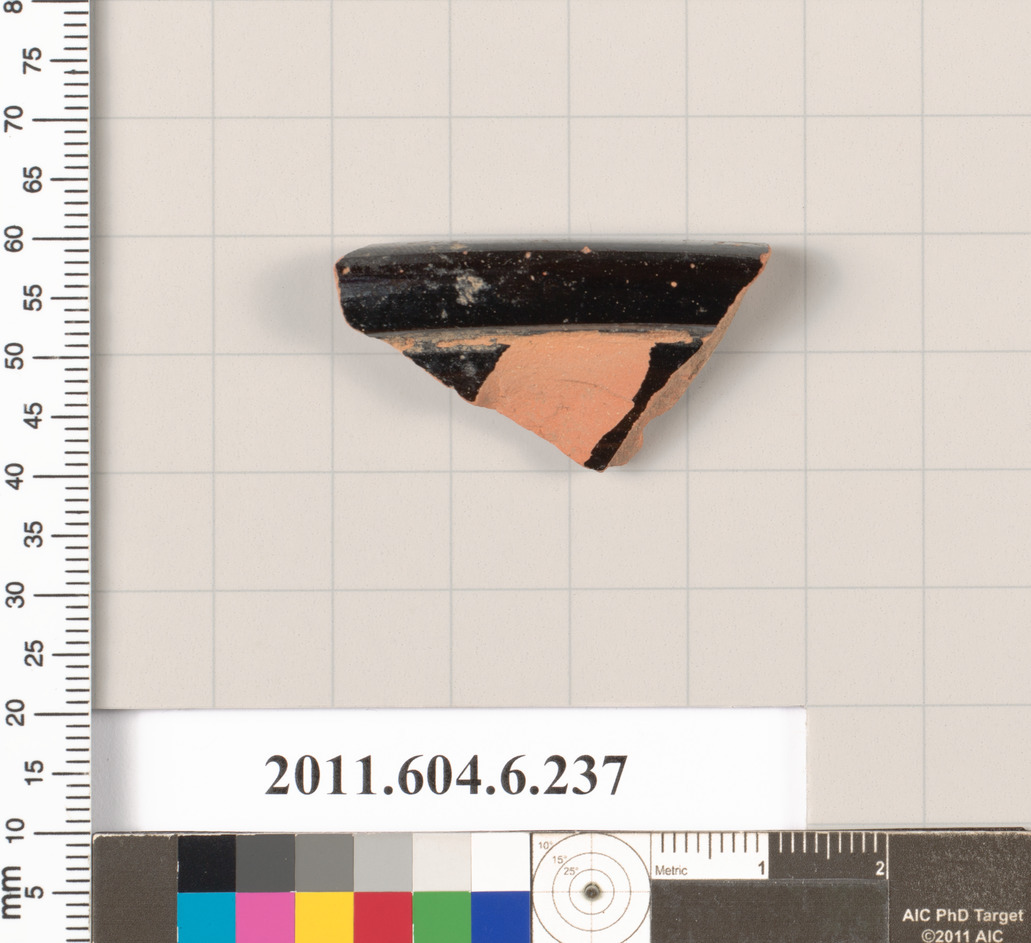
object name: fragment of a bowl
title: Terracotta fragment of a bowl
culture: greek, attic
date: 500-301 BCE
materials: terracotta